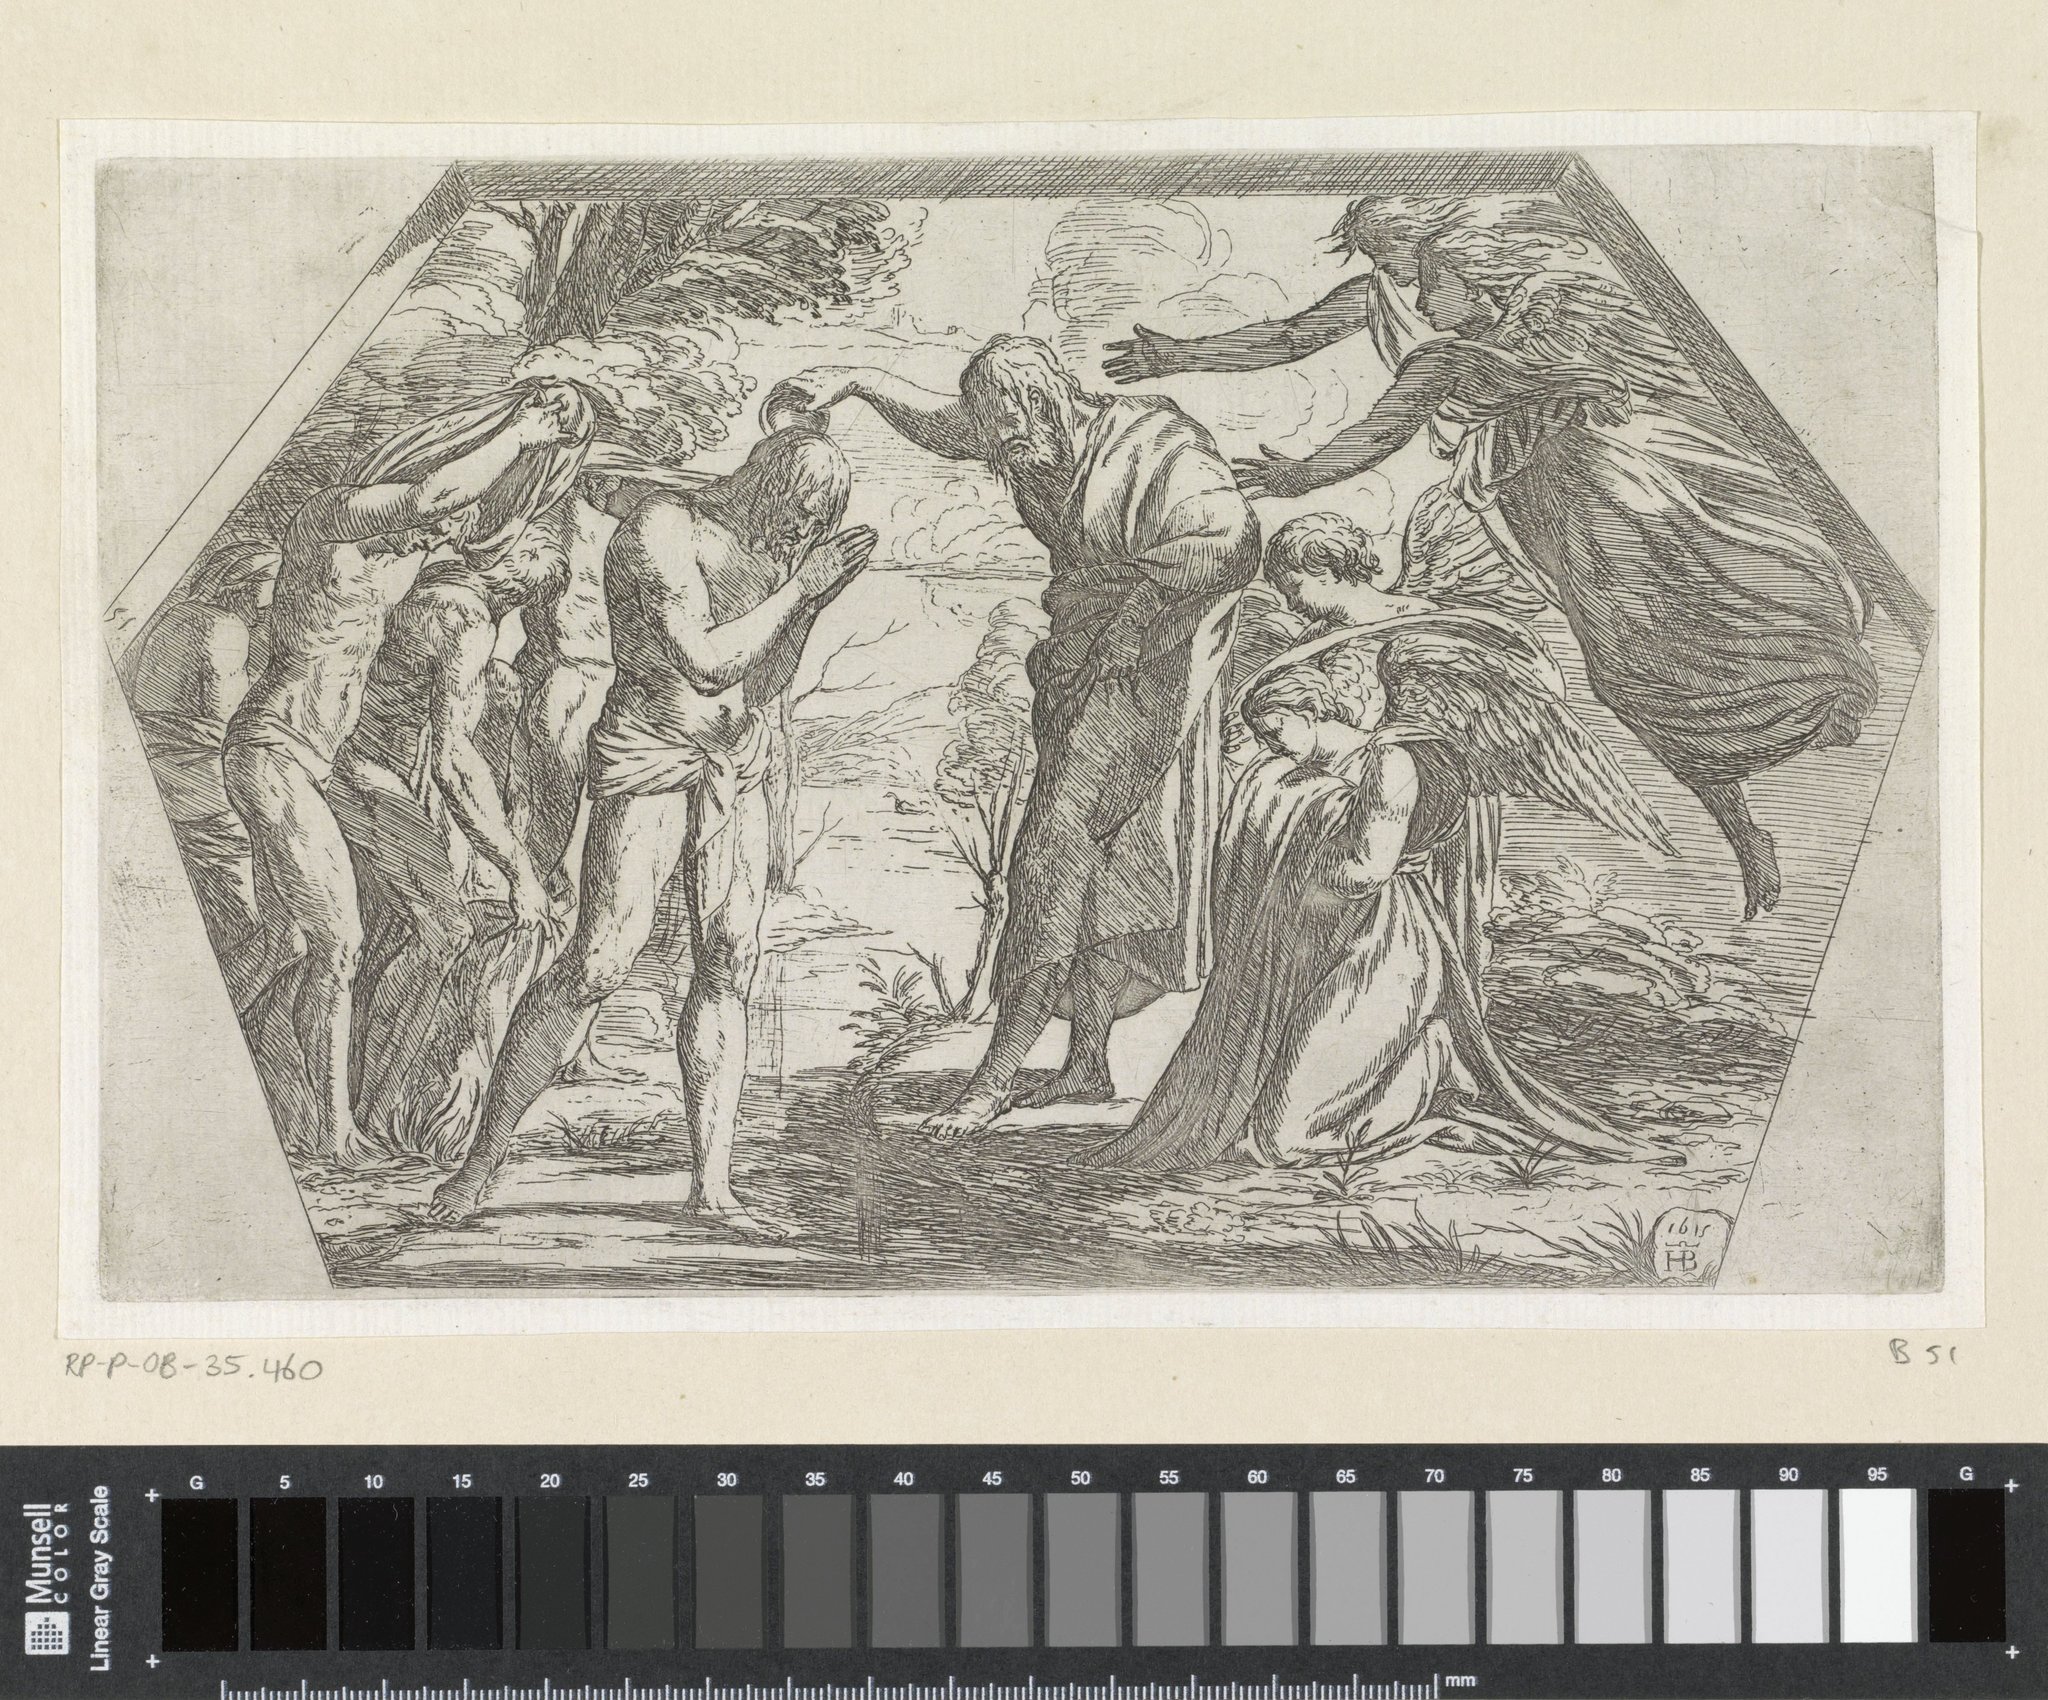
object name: print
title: Schilderingen in de Loggia van Rafaël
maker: orazio borgianni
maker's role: print maker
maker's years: 1578-1616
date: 1615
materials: paper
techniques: etching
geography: italy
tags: baptism of christ in the river jordan: john the baptist pouring out water on christ's head: the holy ghost descends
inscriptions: collector's mark: Lugt 2165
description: Christus wordt gedoopt door Johannes de Doper in de rivier de Jordaan. Achter Johannes knielen en zweven engelen.